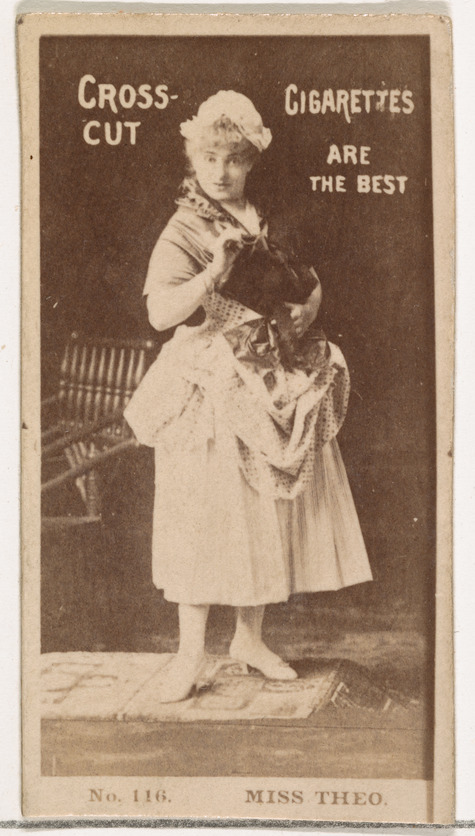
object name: print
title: Card Number 116, Miss Theo, from the Actors and Actresses series (N145-2) issued by Duke Sons & Co. to promote Cross Cut Cigarettes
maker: w. duke, sons & co.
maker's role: publisher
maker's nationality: american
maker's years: 1870-1920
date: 1880-1889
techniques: albumen silver print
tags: portraits,women,actresses